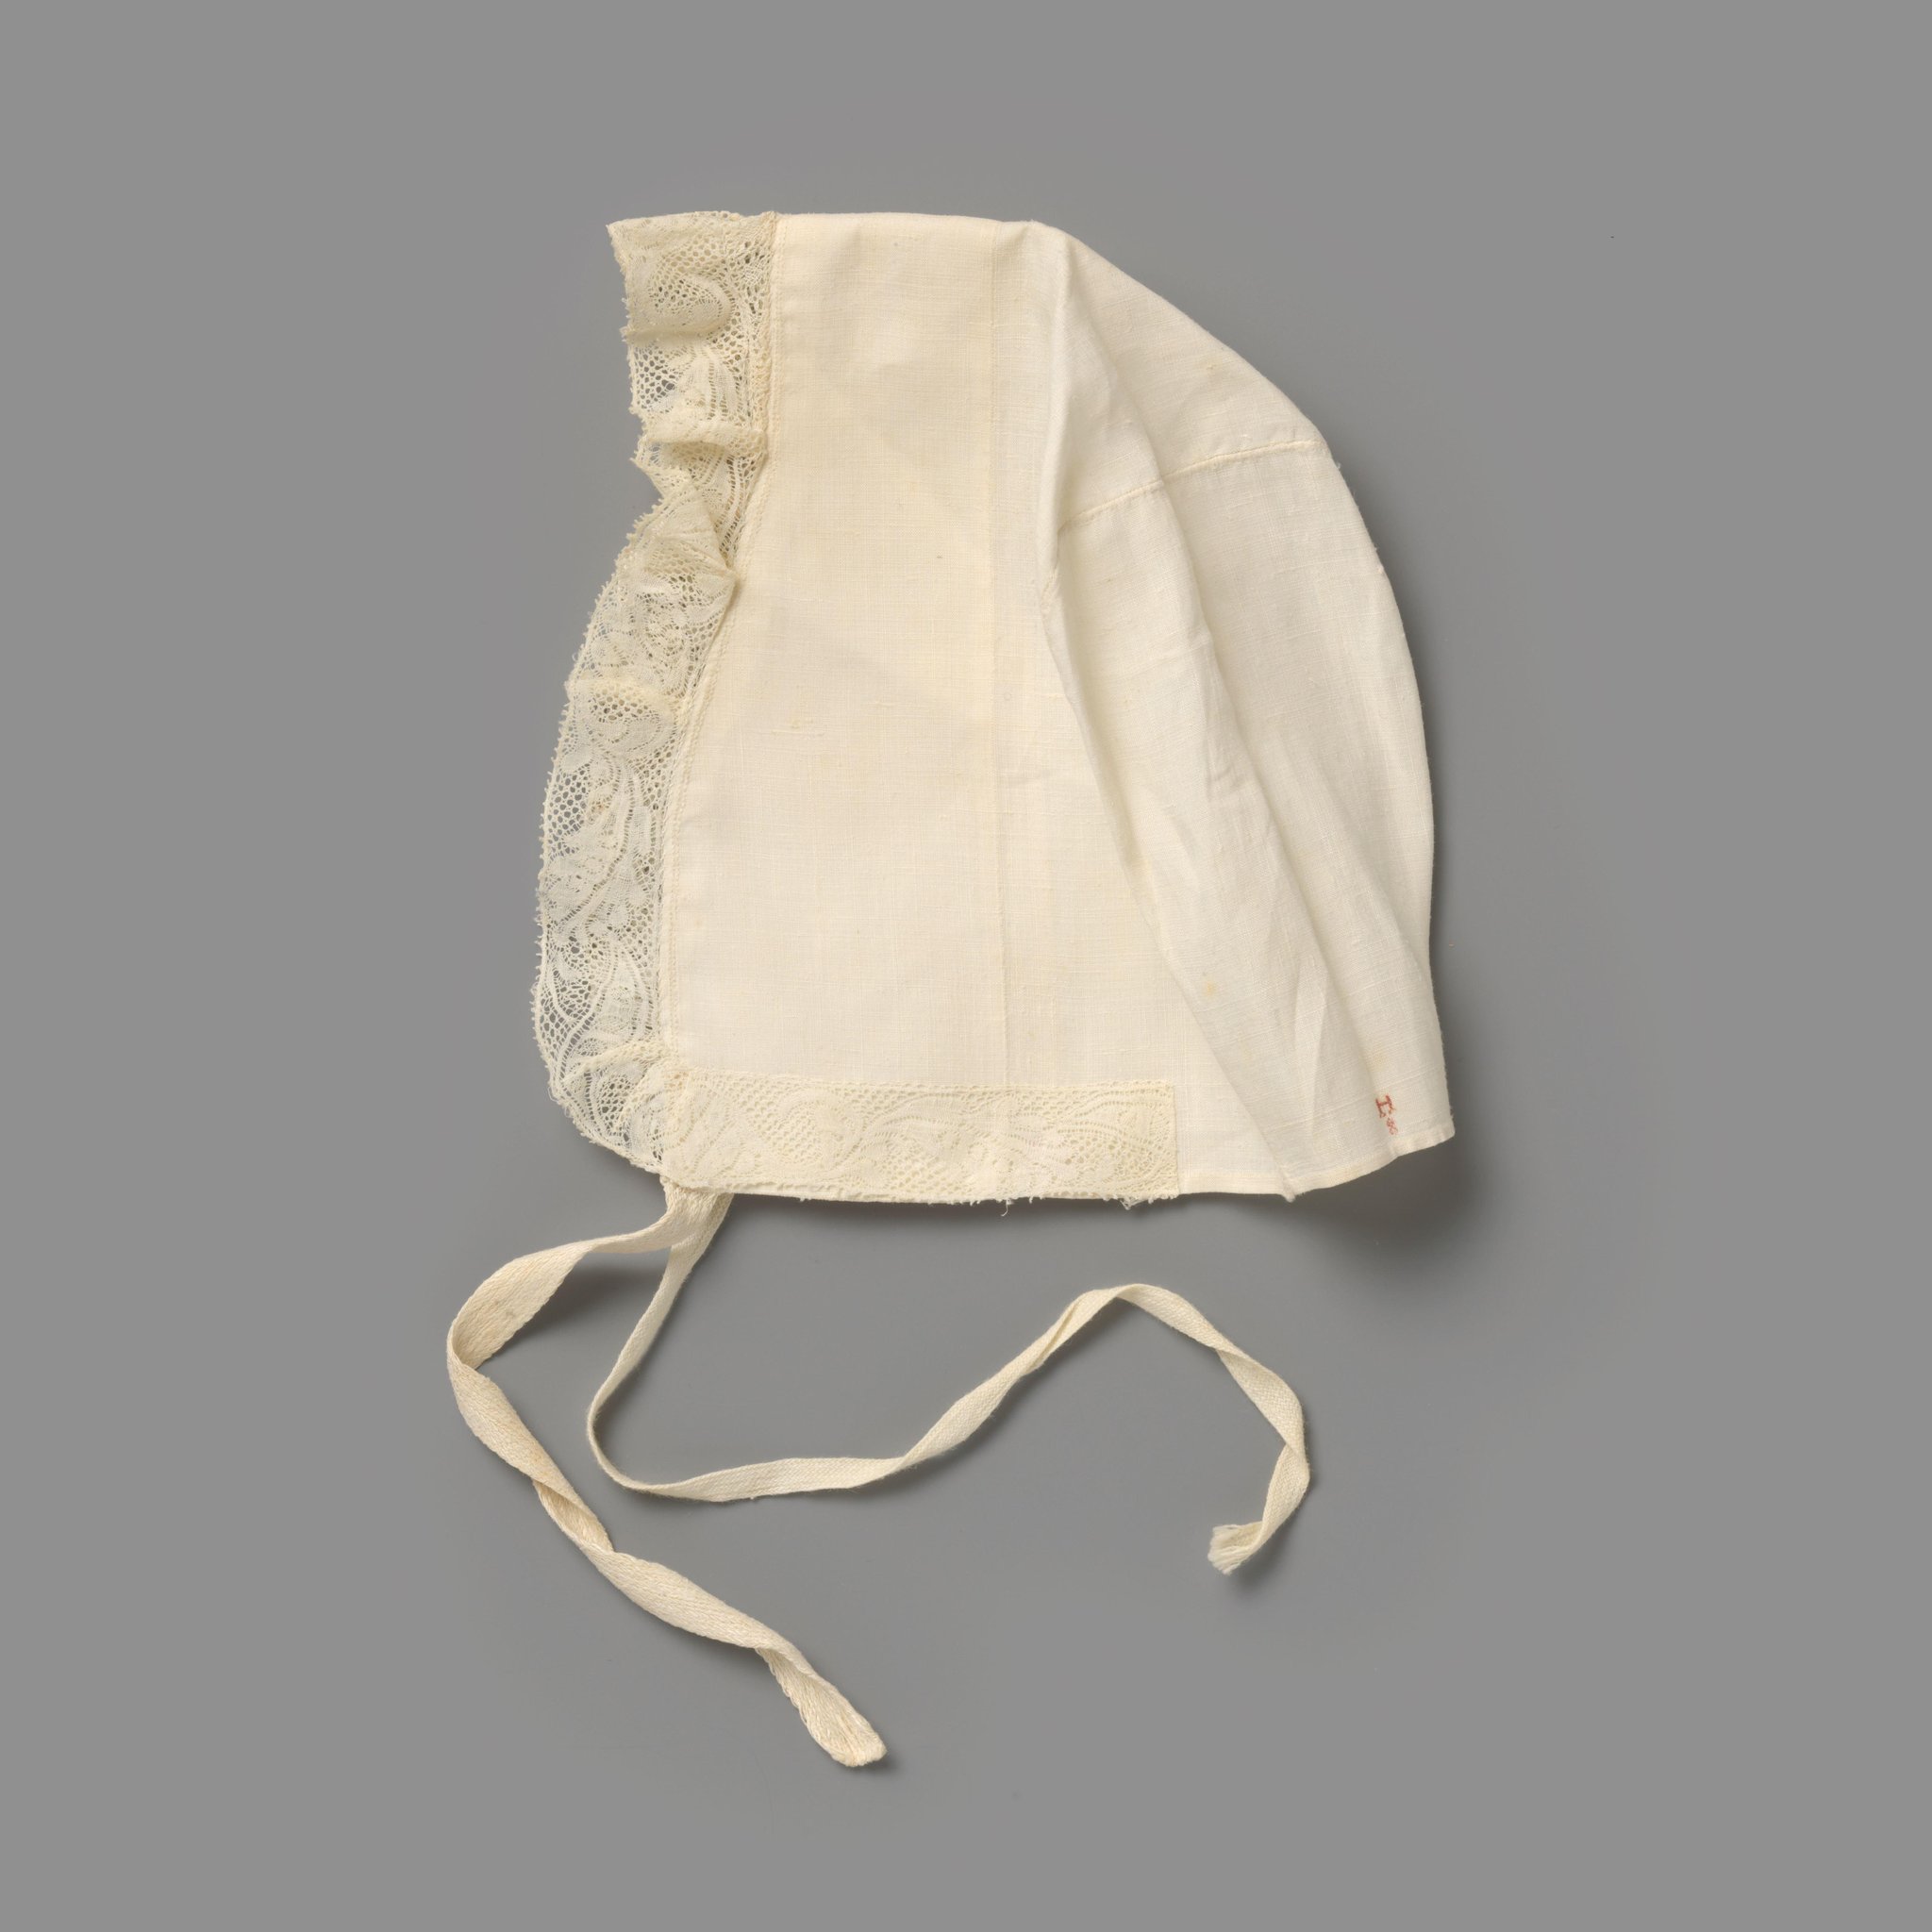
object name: cap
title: Kindermuts van wit katoen (?) afgezet met kant en genummerd in rode kruissteek met H8; één strikband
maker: Anonymous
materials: cotton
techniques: cross stitching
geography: europe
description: Linnen baby onder mutsjes, met kant langs voor en zijkanten gem H8.